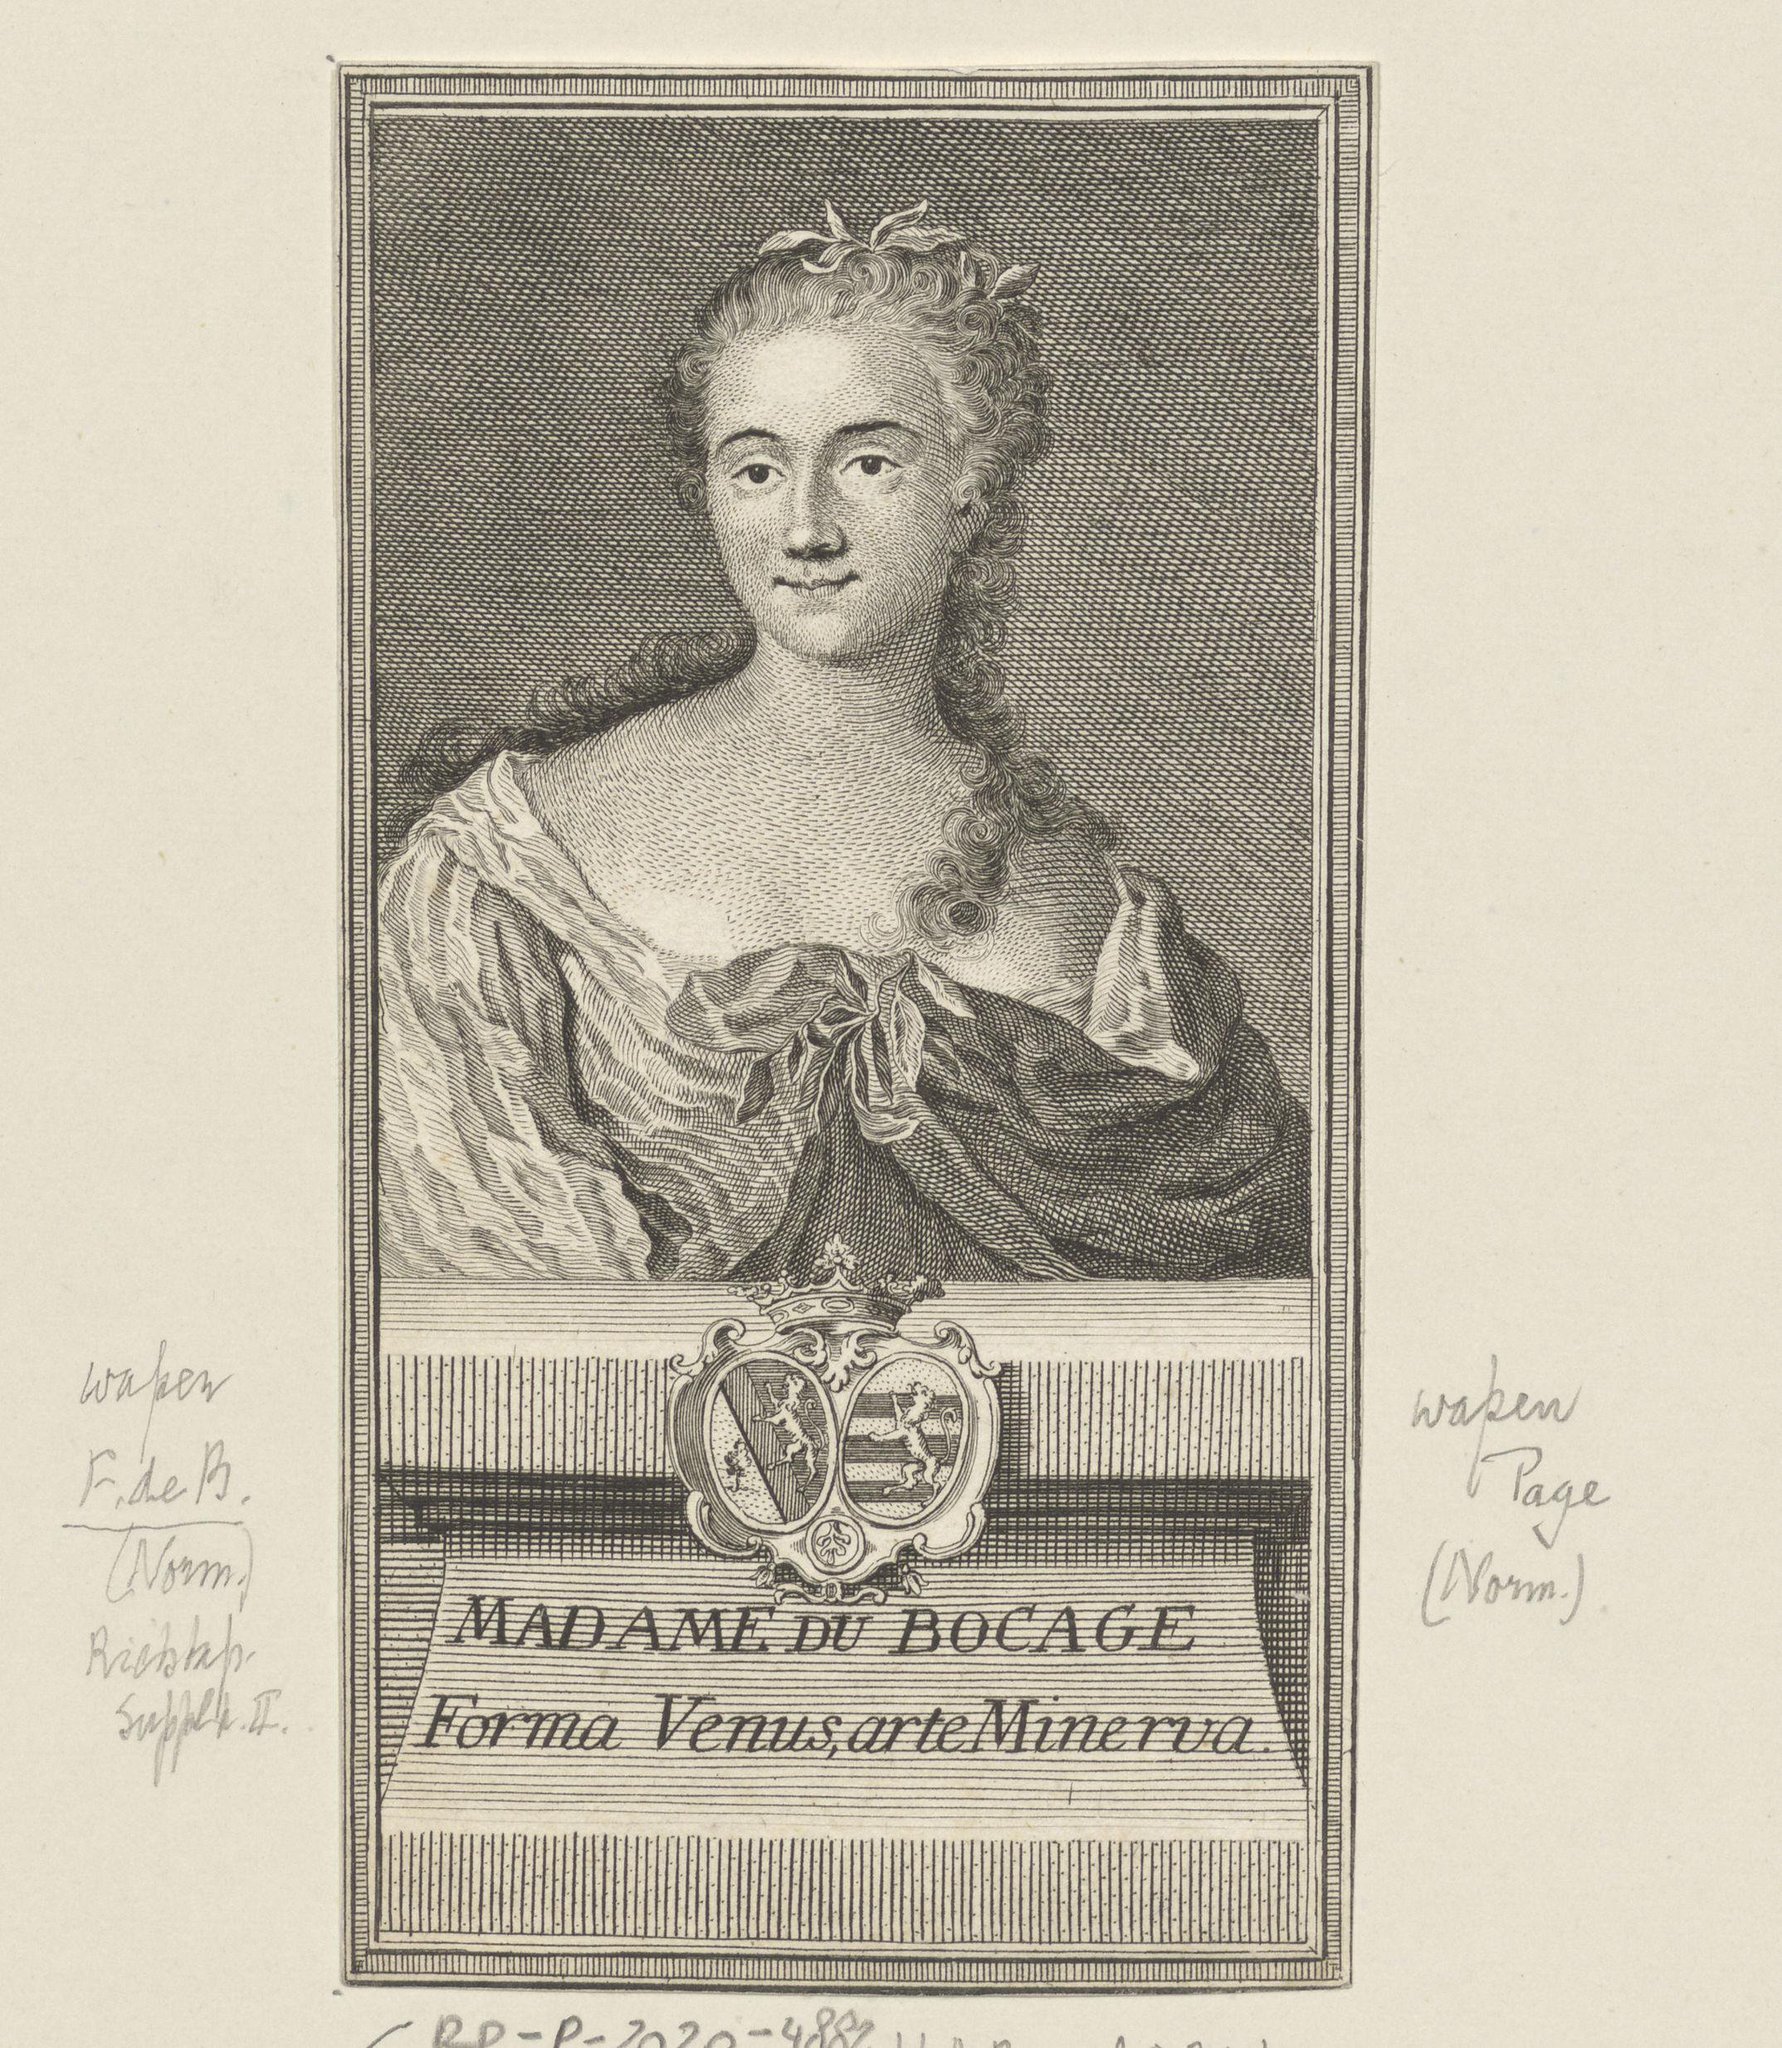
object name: print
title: Portret van Anne-Marie du Boccage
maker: johann david schleuen (i)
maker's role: print maker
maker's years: 1711-1774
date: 1762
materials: paper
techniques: engraving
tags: historical persons, portrait of a writer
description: Prent mogelijk gebruikt in: Boccage, Anne-Marie du. Die Columbiade, oder der in die neue Welt übergebrachte Glaube (...). Glogau en Leipzig: Christian Friedrich Günther 1762.